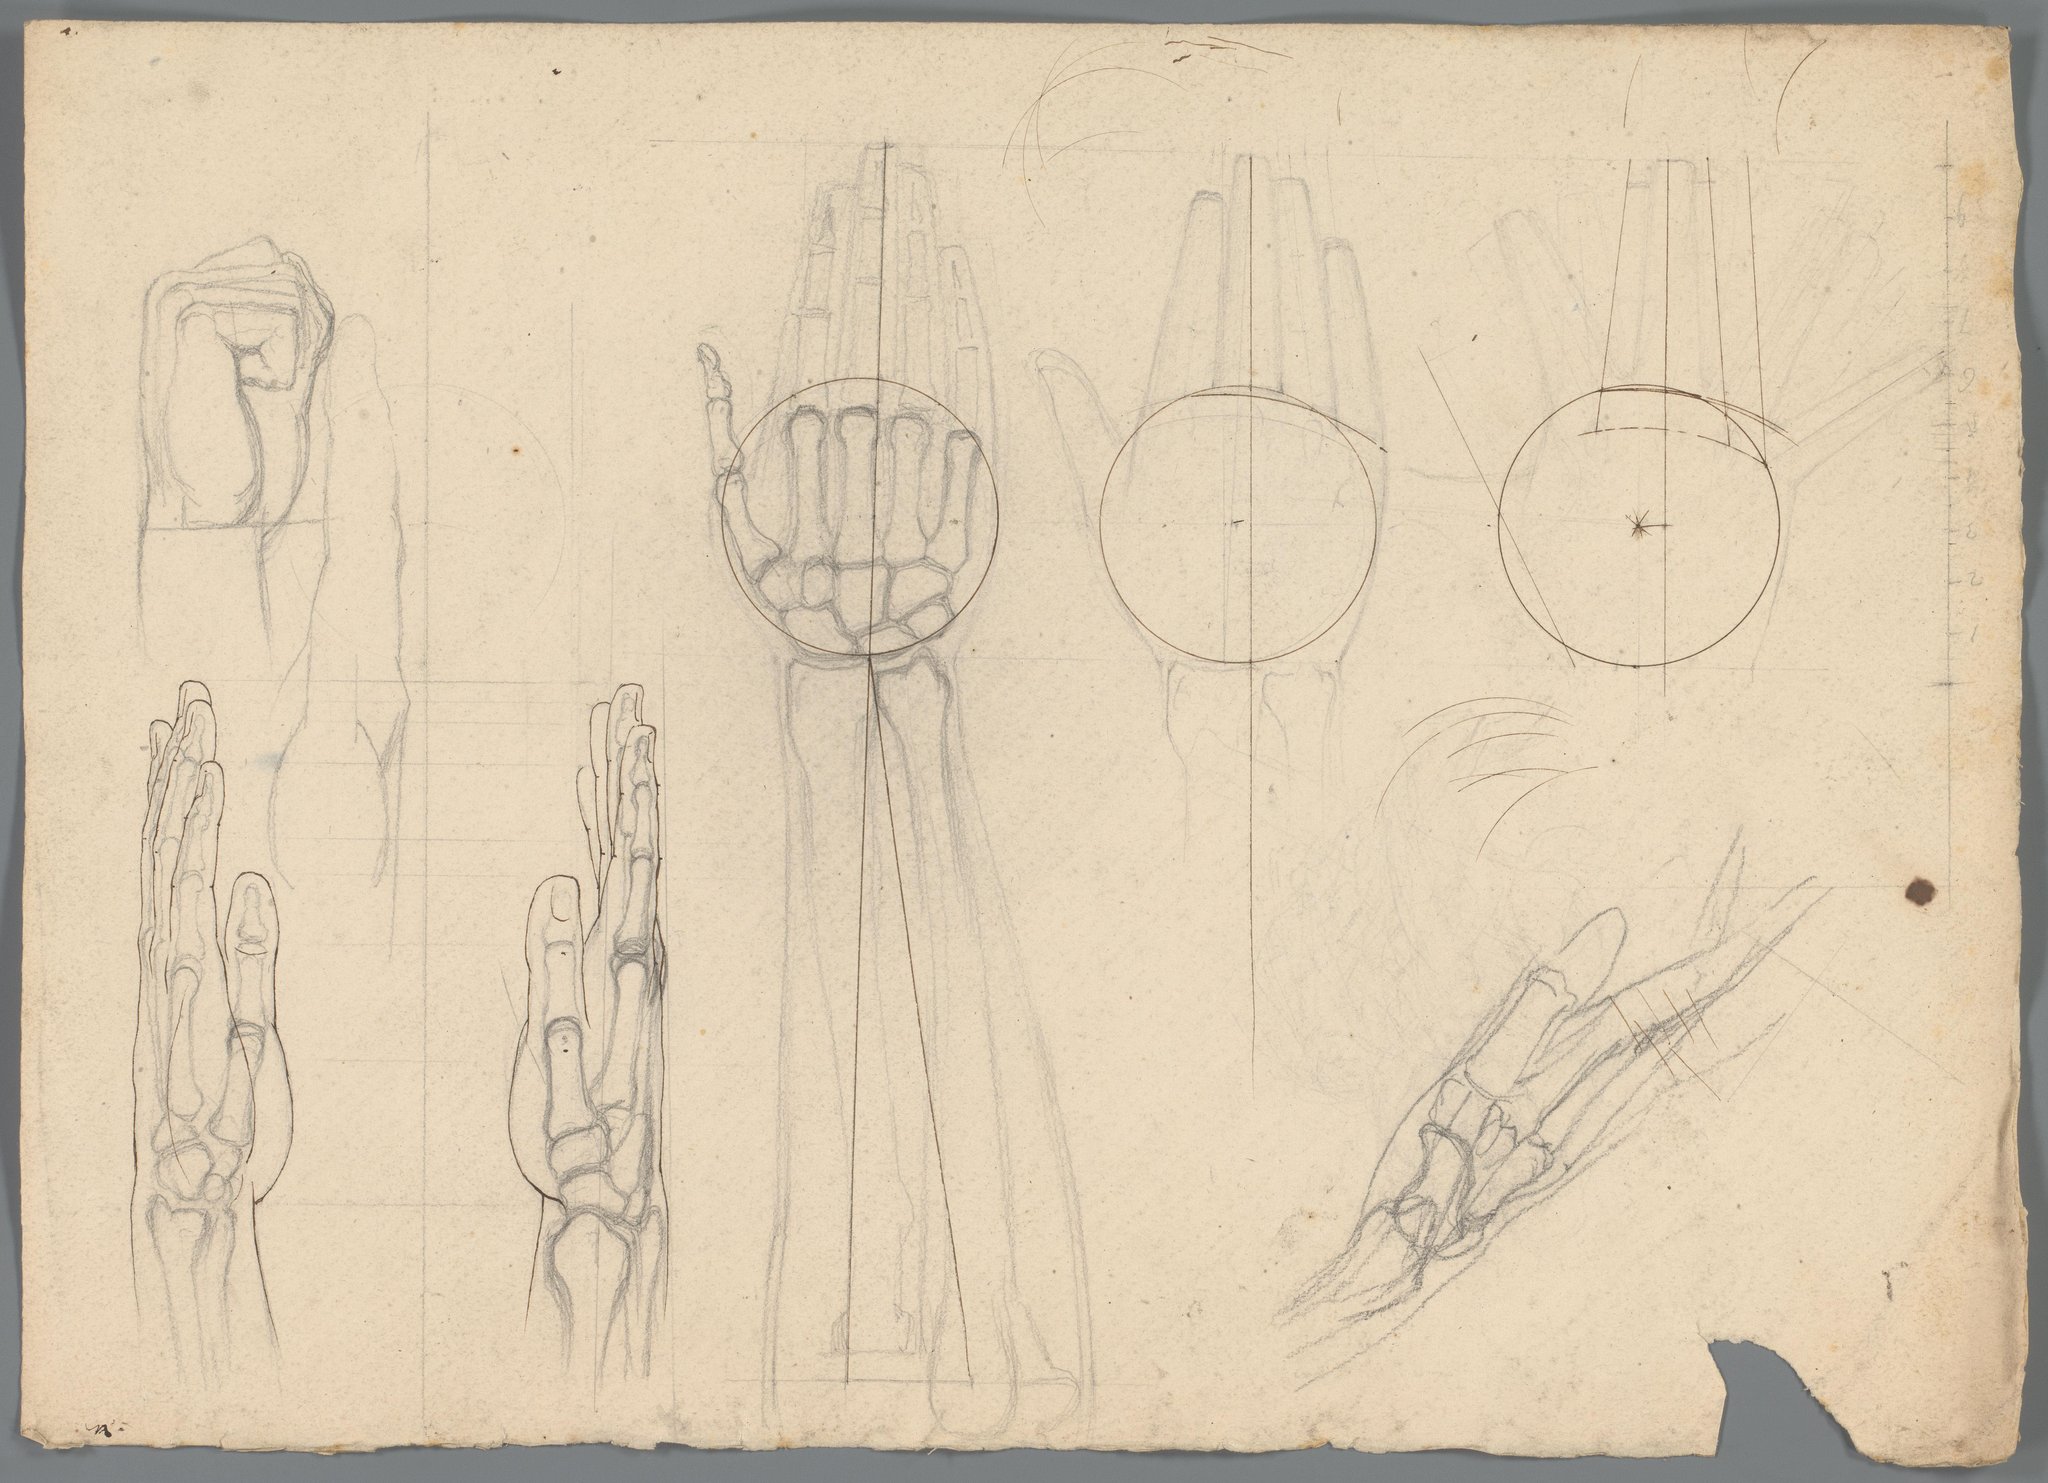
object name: drawing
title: Anatomische studie van de botten in een hand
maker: jacobus everhardus josephus van den berg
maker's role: draughtsman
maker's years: 1802-1861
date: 1812-1861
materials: ink, paper, pencil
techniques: pen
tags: carpus and metacarpus, parts of the hand, phalanges of the fingers